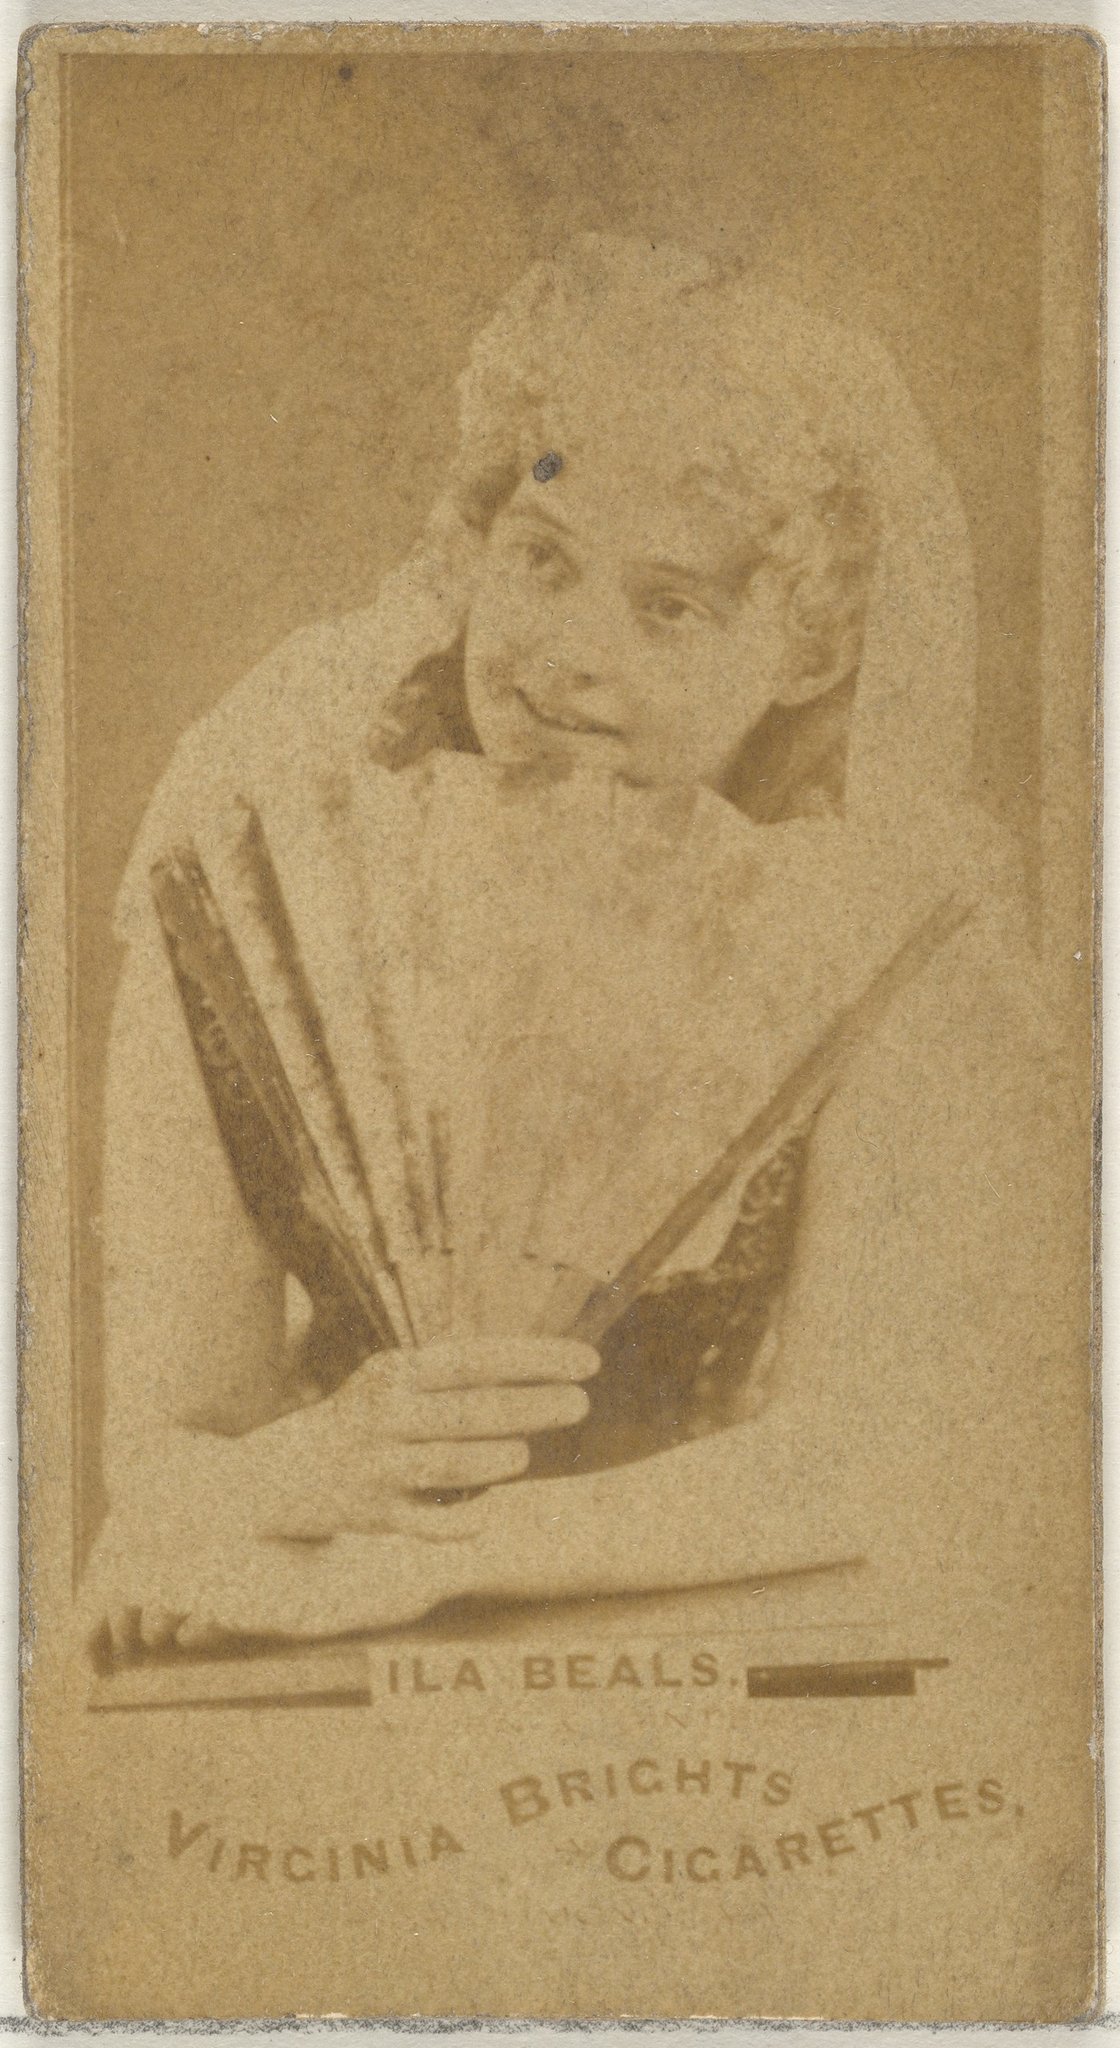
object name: photograph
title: Ila Beals, from the Actors and Actresses series (N45, Type 1) for Virginia Brights Cigarettes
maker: allen & ginter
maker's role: publisher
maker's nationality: american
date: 1888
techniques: albumen silver print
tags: fans,portraits,women,actresses